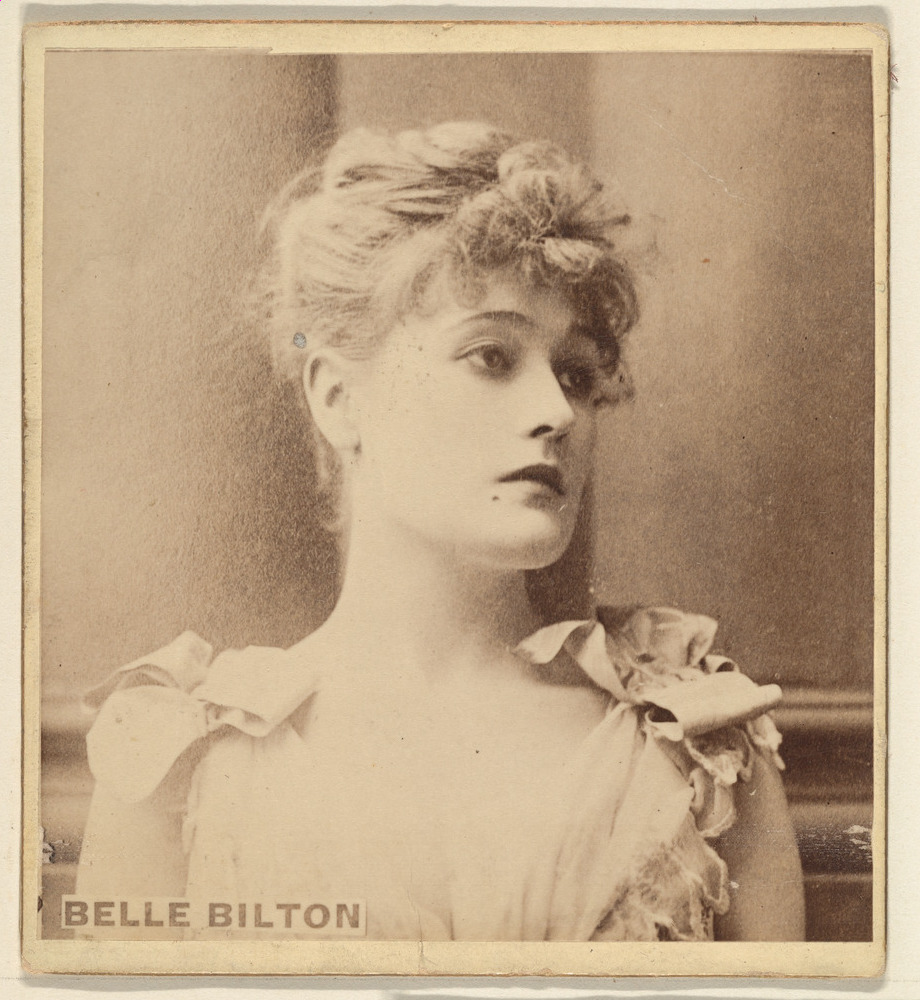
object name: photograph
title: Belle Bilton, from the Actresses series (N246), Type 2, issued by Kinney Brothers to promote Sporting Extra Cigarettes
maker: kinney brothers tobacco company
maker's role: publisher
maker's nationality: american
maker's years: 1869-2011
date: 1890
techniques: albumen silver print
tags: portraits,women,actresses